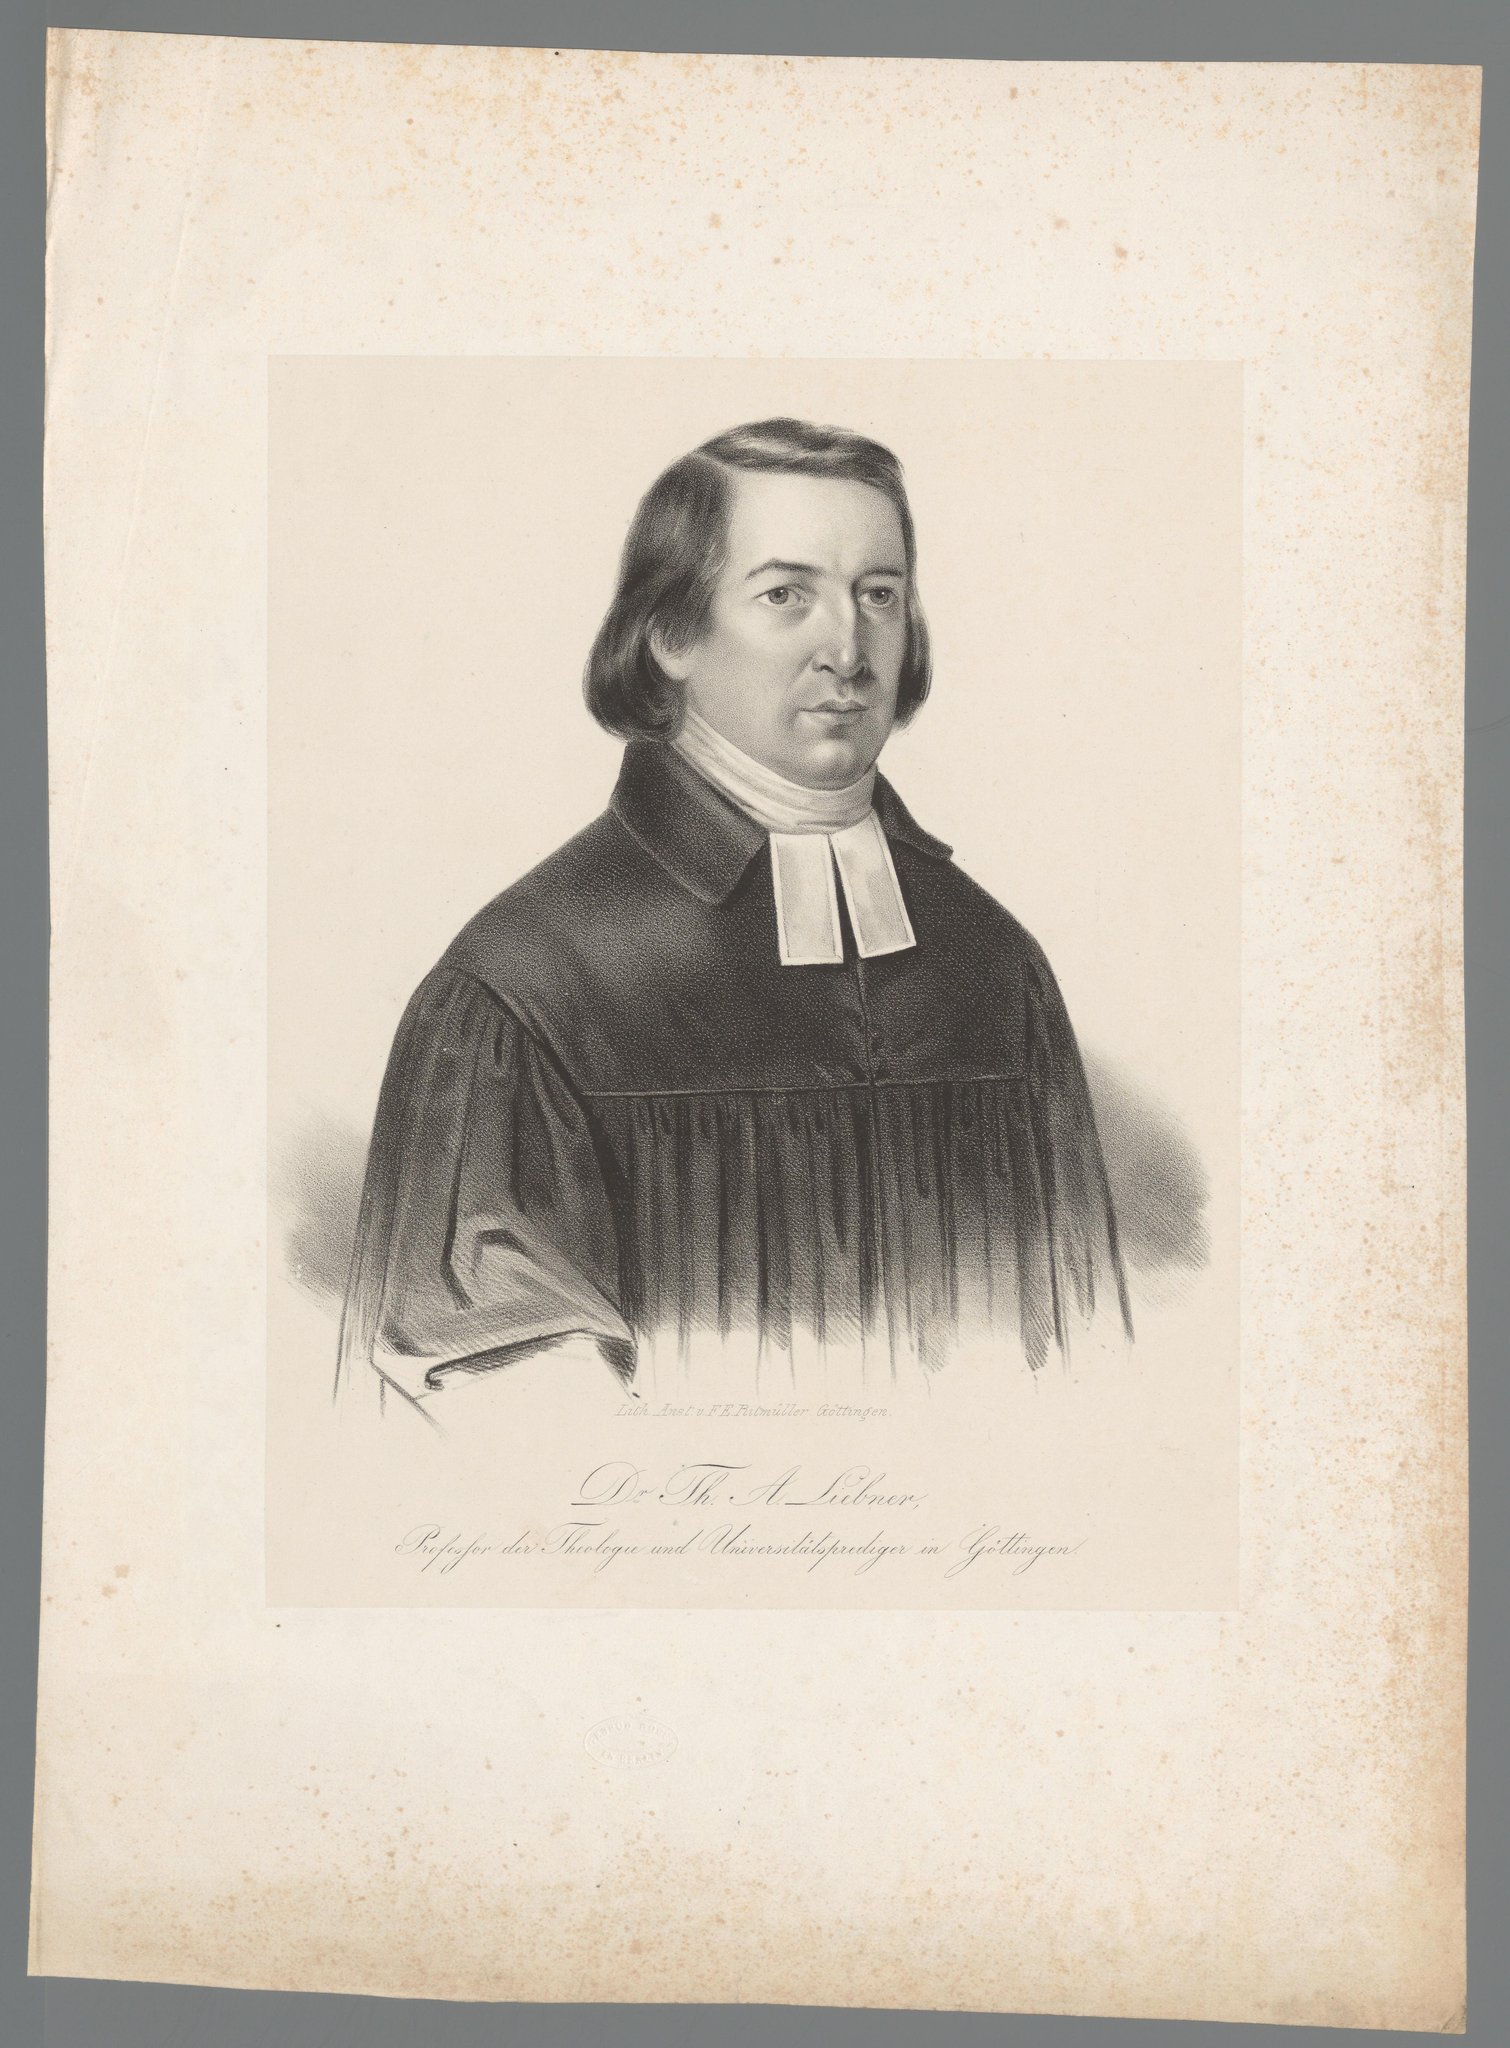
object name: print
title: Portret van Karl Theodor Albert Liebner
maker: friedrich eduard ritmüller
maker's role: printer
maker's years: 1805-1869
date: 1830-1863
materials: paper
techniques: lithograph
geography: berlin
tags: theologian, historical persons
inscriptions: collector's mark: Lugt 2228, check stamp: Lugt 2141c